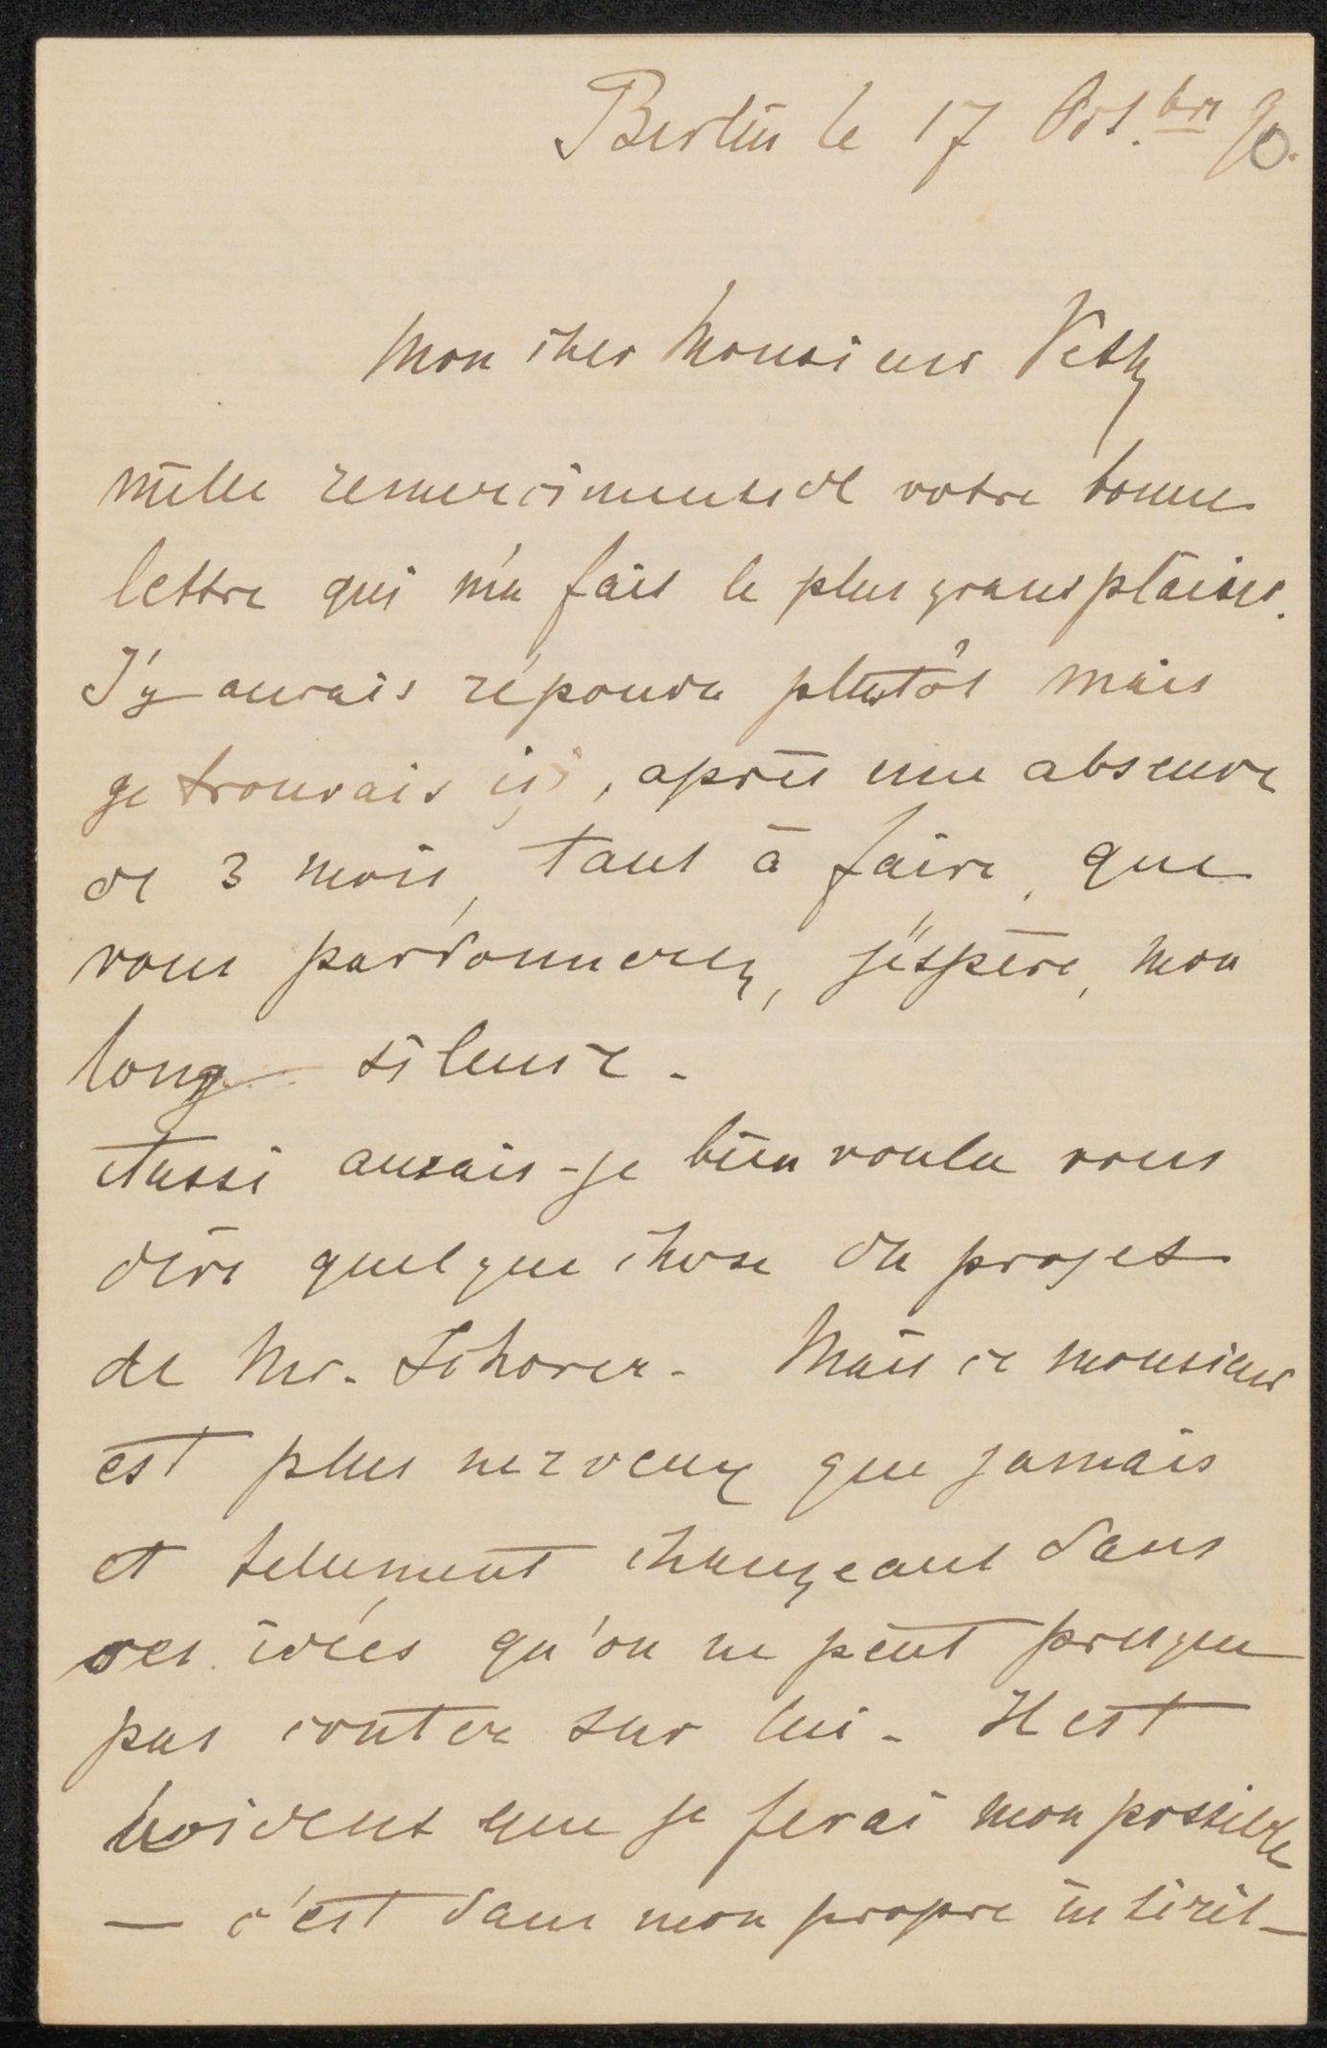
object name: letter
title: Brief aan Jan Veth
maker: max liebermann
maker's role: draughtsman, print maker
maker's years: 1847-1935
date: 1890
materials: ink, paper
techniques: pen, writing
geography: berlin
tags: draughtsman, jan veth, berlin, painter, print maker, artist, karl köpping, amsterdam, sculptor, wilhelmus bernardus gerardus molkenboer, publisher, j.h. schorer, the graphic arts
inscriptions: collector's mark: ‘RPK’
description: Opgenomen in: Ernst Braun, Max Liebermann: Briefe 1869-1895, Baden-Baden: Deutscher Wissenschafts-Verlag, 2011, Band 1, p. 144-145.